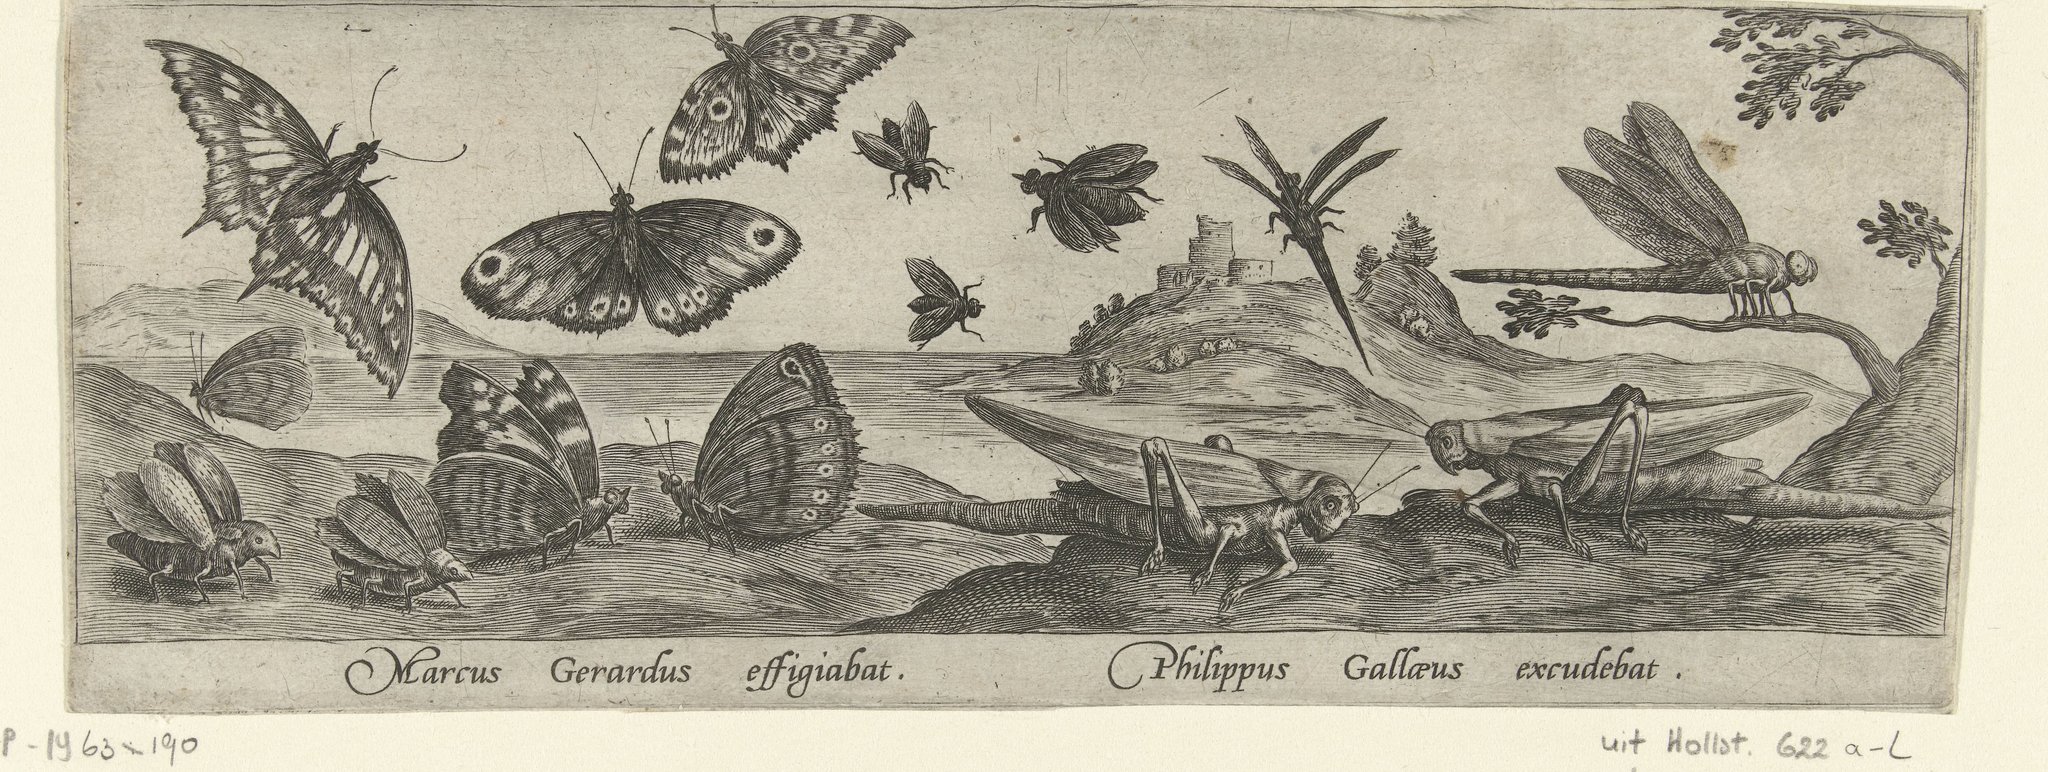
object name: print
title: Vlinders, kevers en sprinkhanen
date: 1547-1590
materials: paper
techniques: engraving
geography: antwerp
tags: insects: butterfly, insects: grass-hopper, insects: beetle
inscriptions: collector's mark: Lugt 2228, collector's mark: Lugt 2760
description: Vlinders, kevers en sprinkhanen. De prent maakt deel uit van een prentserie over vogels en vlinders.